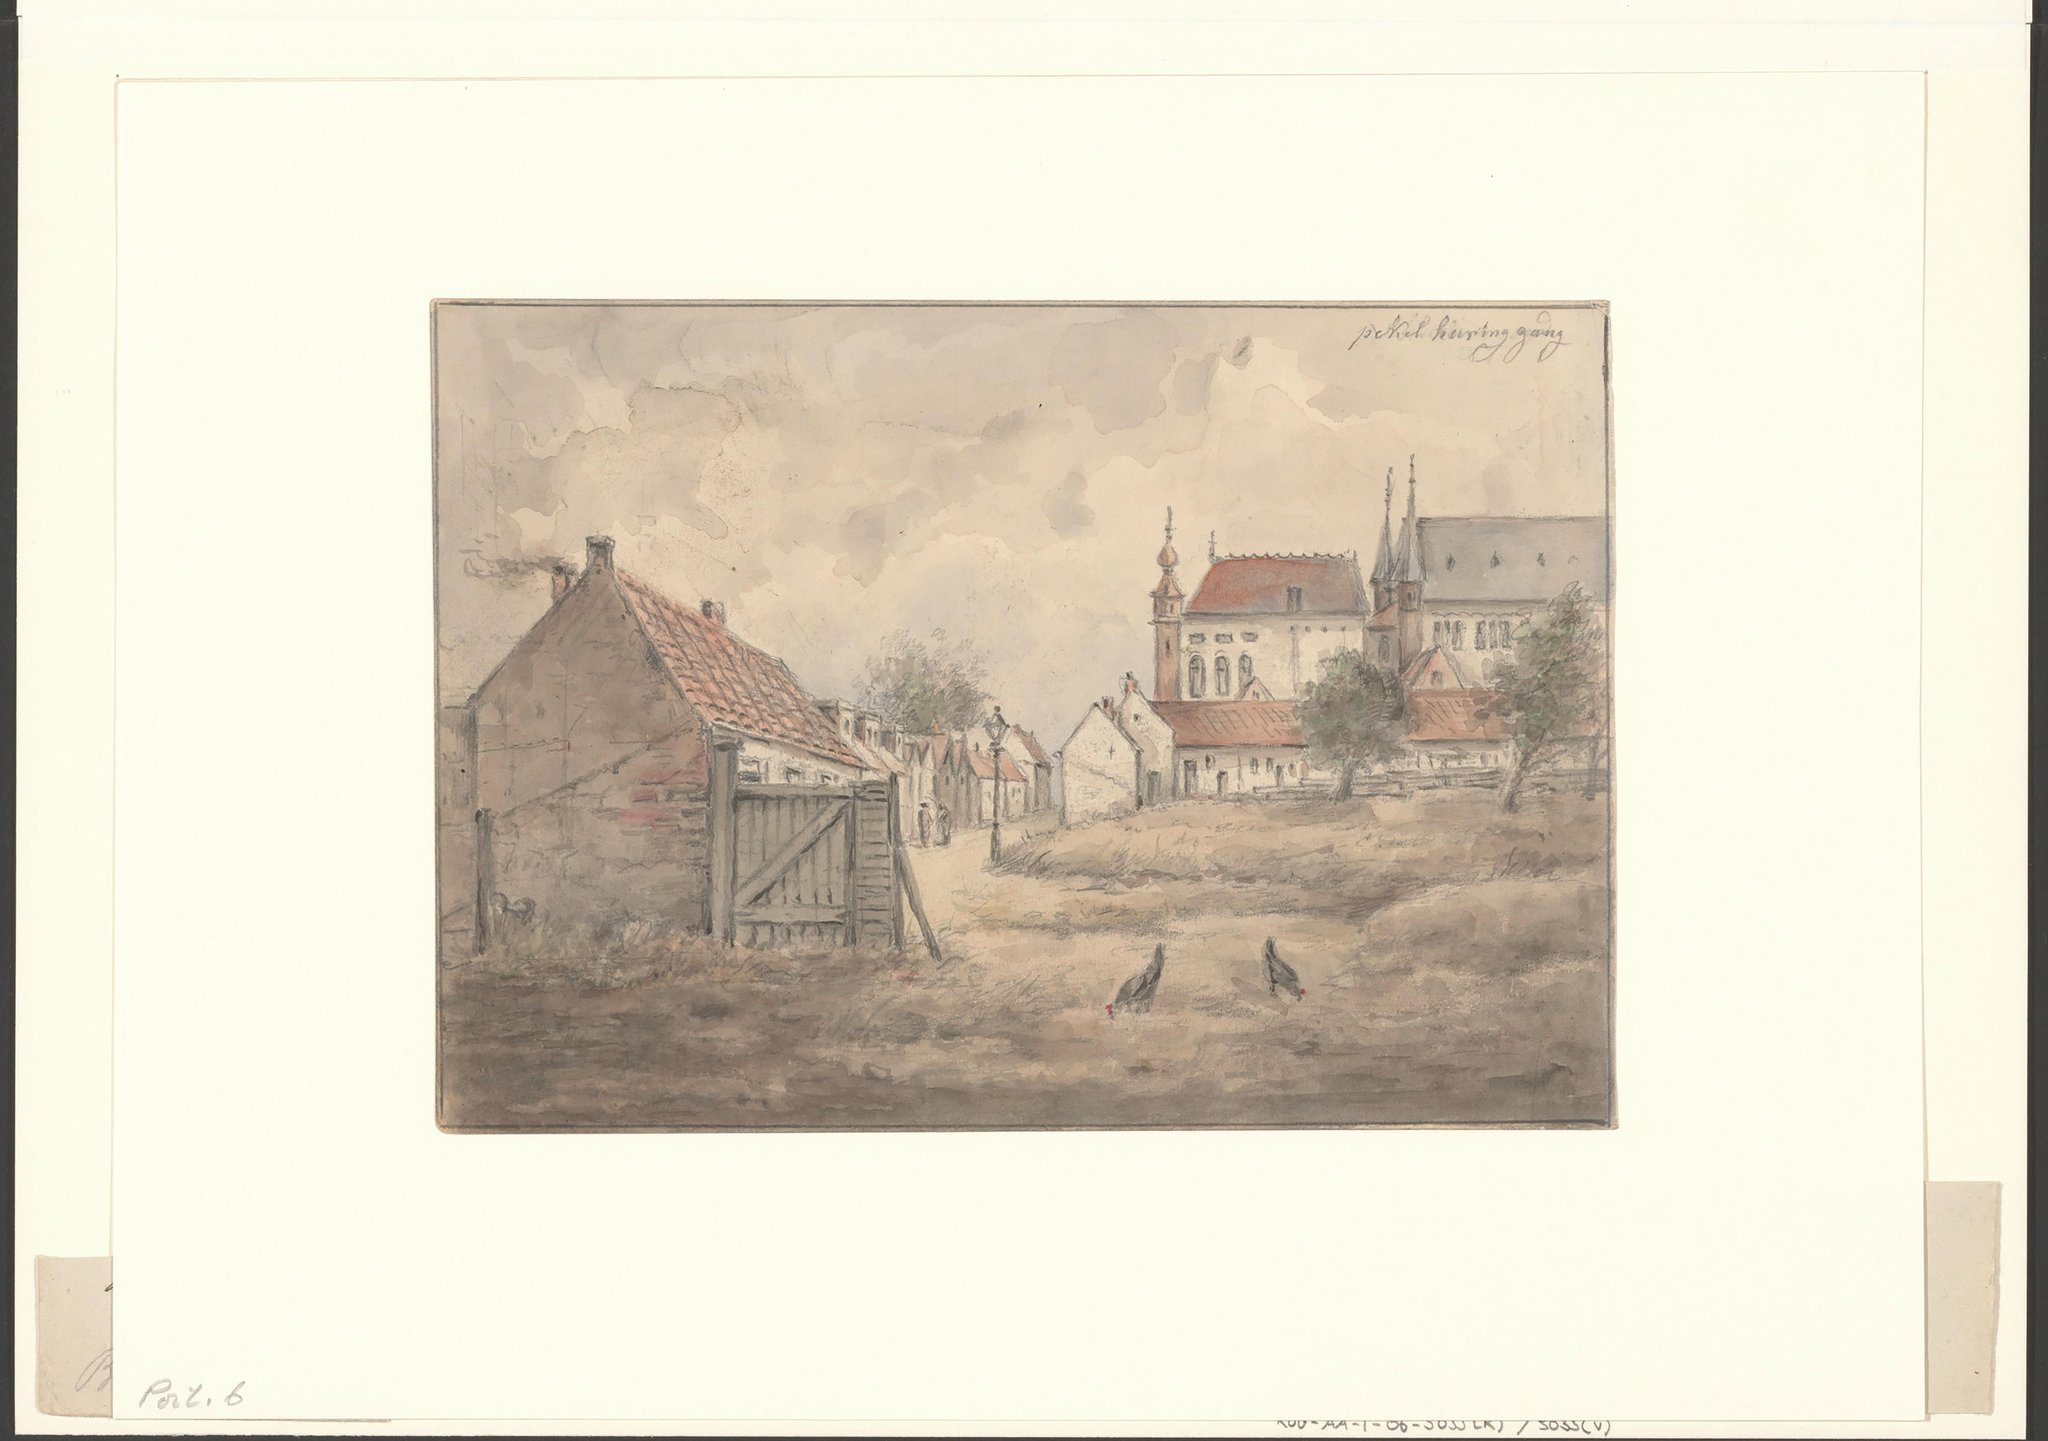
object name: drawing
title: Gezicht op de Pekelharinggang achter kerk De Liefde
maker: albert martin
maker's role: draughtsman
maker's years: 1827-1900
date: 1837-1900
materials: paper, pencil, watercolor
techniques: brush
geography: amsterdam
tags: city-view in general; 'veduta', the usual house or row of houses, lane, alley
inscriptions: inscription: ‘door A. Martin (...) D.C. Meijer. Jr’, inscription: ‘Port. 6’, collector's mark: ‘6’ Lugt 1641b, inscription: ‘pekelharinggang’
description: Onderwerpsrubriek binnen de Atlas Amsterdam: Buijskade, Catskade (Jacob), Clercqstraat (de), Commelinstraat, Costakade (da), Cuypstraat (Albert), Czaar Peterstraat.